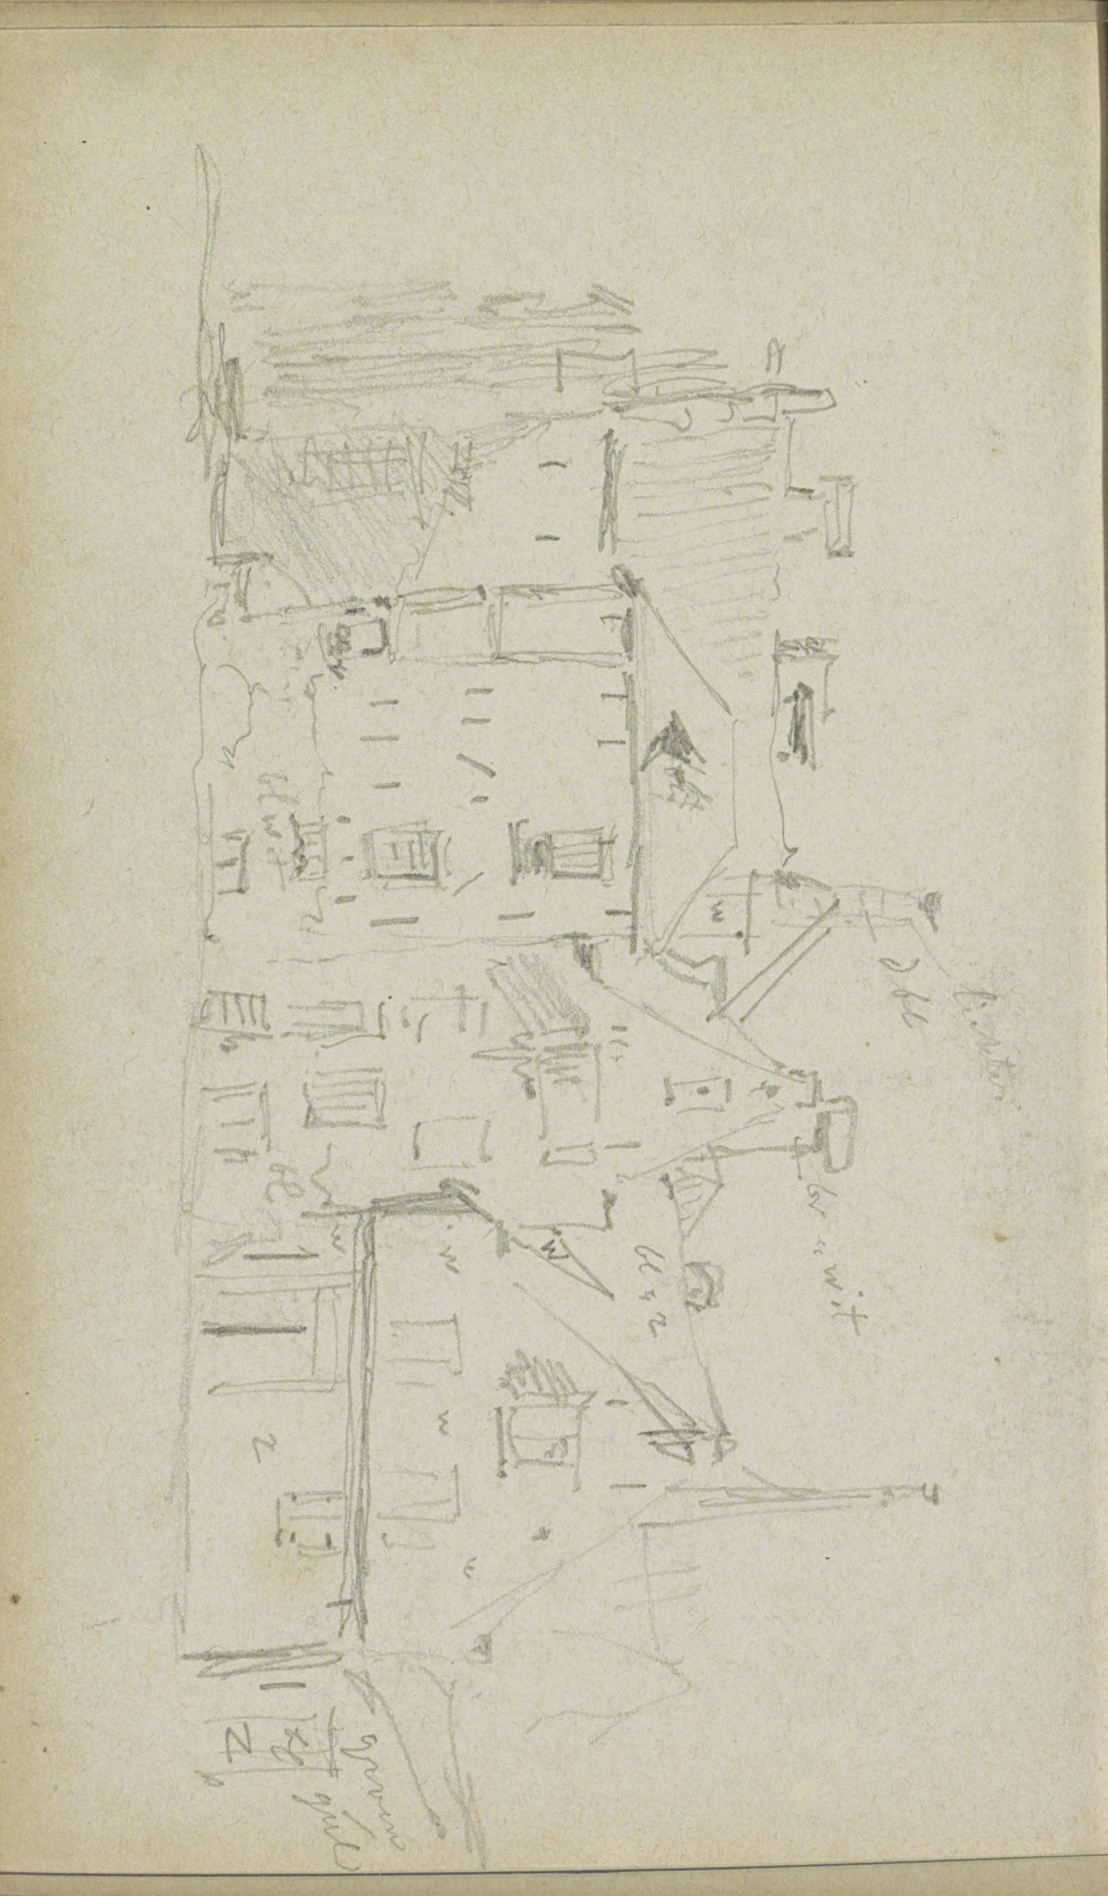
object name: sketchbook leaf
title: Gezicht op een straat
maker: adrianus eversen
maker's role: draughtsman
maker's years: 1818-1897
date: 1828-1897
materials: paper, pencil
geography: netherlands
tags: urban housing, street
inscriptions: kleurnotitie, handgeschreven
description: Gezicht op een straat. Blad 41 verso uit een schetsboek met 69 bladen vervaardigd in de omgeving van Delft, Rotterdam, Oudewater en Harlingen.